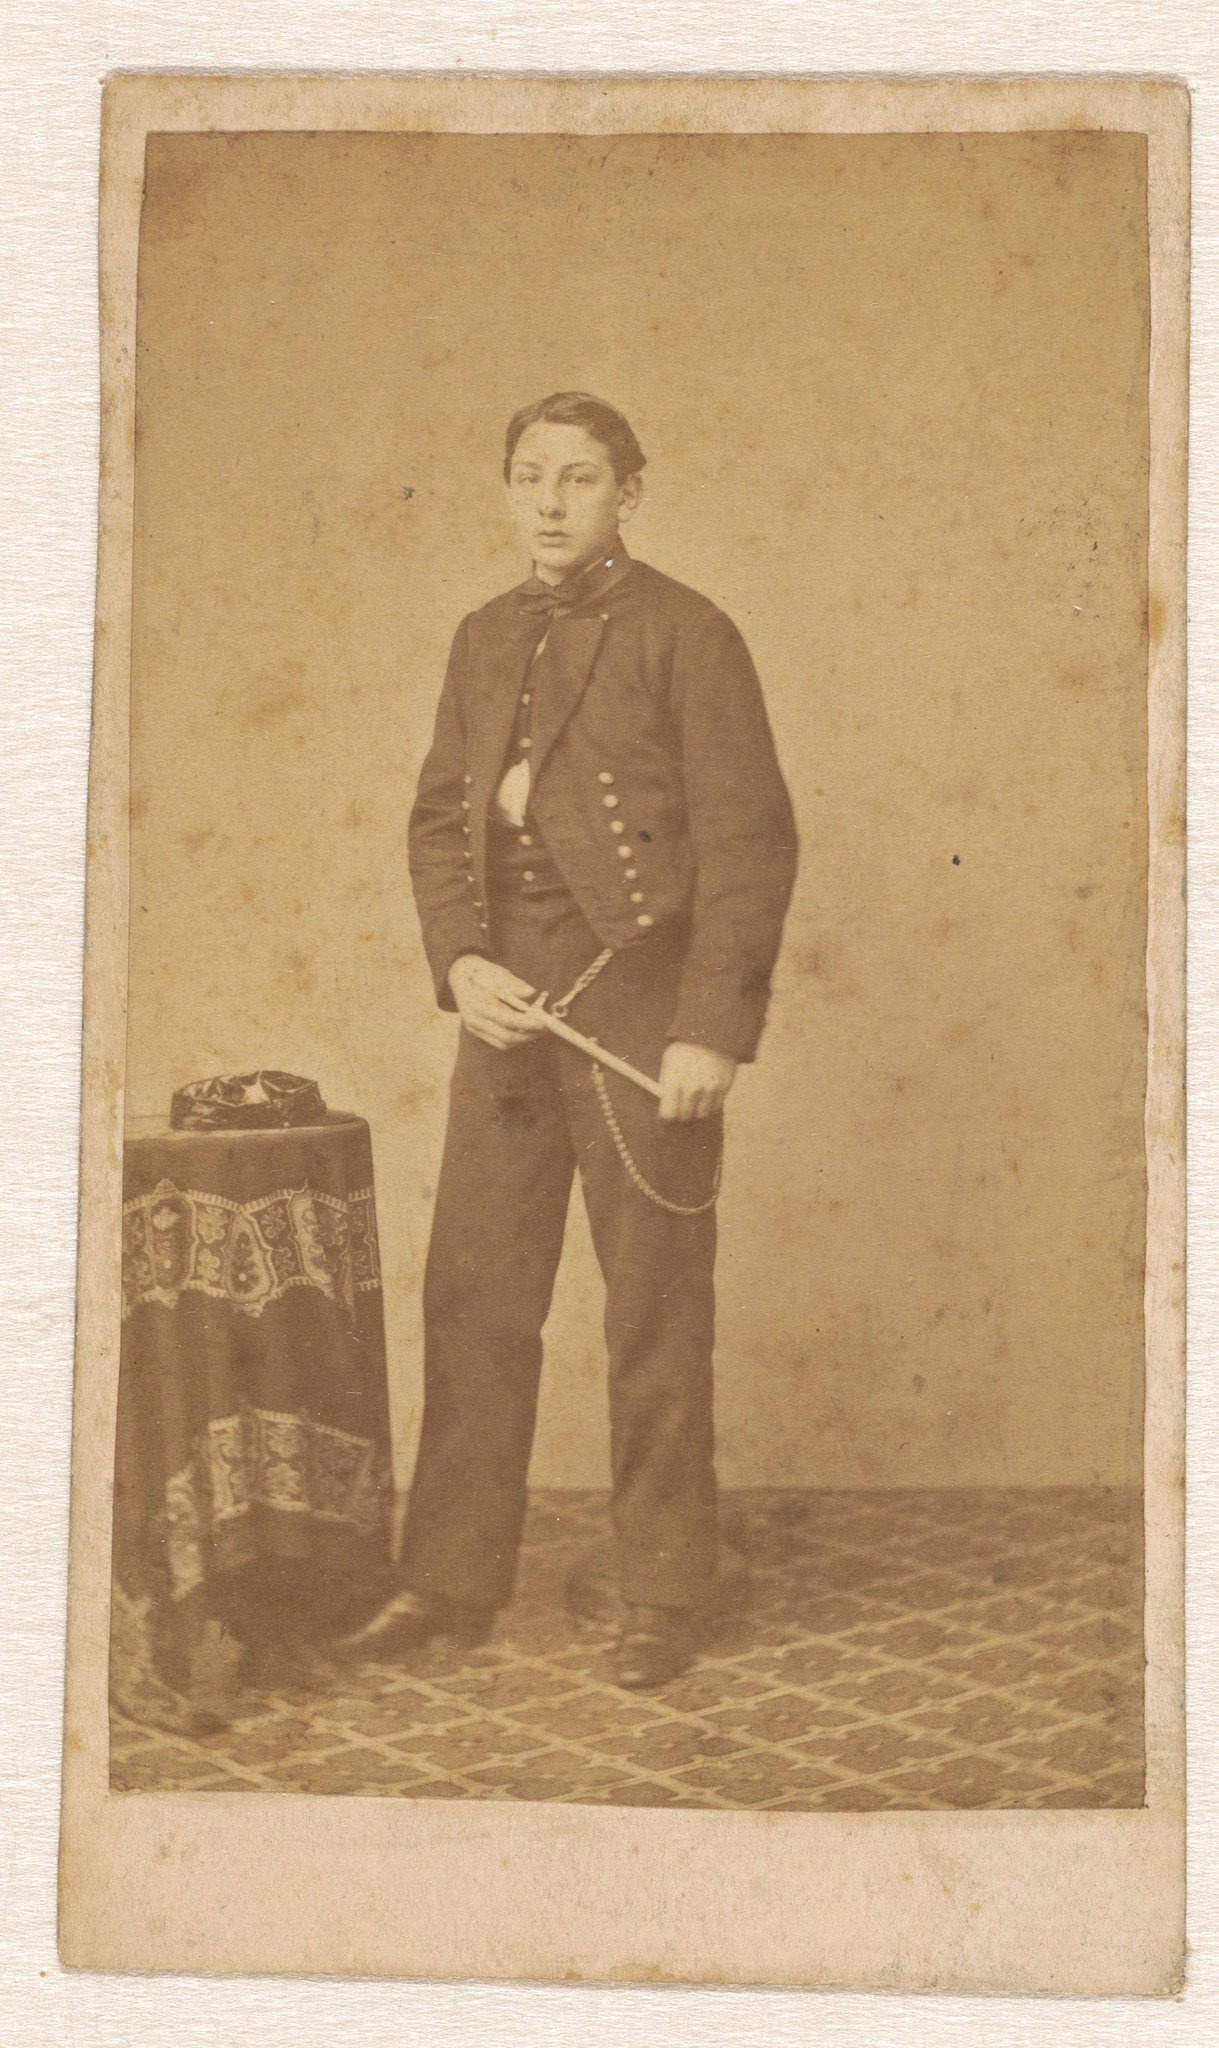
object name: carte de visite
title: W.H. van Braam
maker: confeld von felbert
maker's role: fotograaf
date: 1870-1890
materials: cardboard, paper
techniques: albumen print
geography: arnhem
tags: arnhem, willem hendrik van braam, historical persons, netherlands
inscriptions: signature: ‘Photographish Atelier Confeld von Felbert voorheen Emil Becher Arnhem, hoek Kerkstraat’, annotation: ‘W.H. van Braam’